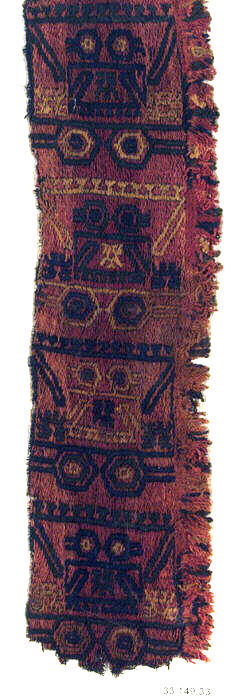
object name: mantle fragment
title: Embroidered Mantle Fragment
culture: paracas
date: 500-101 BCE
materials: animal fiber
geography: peru